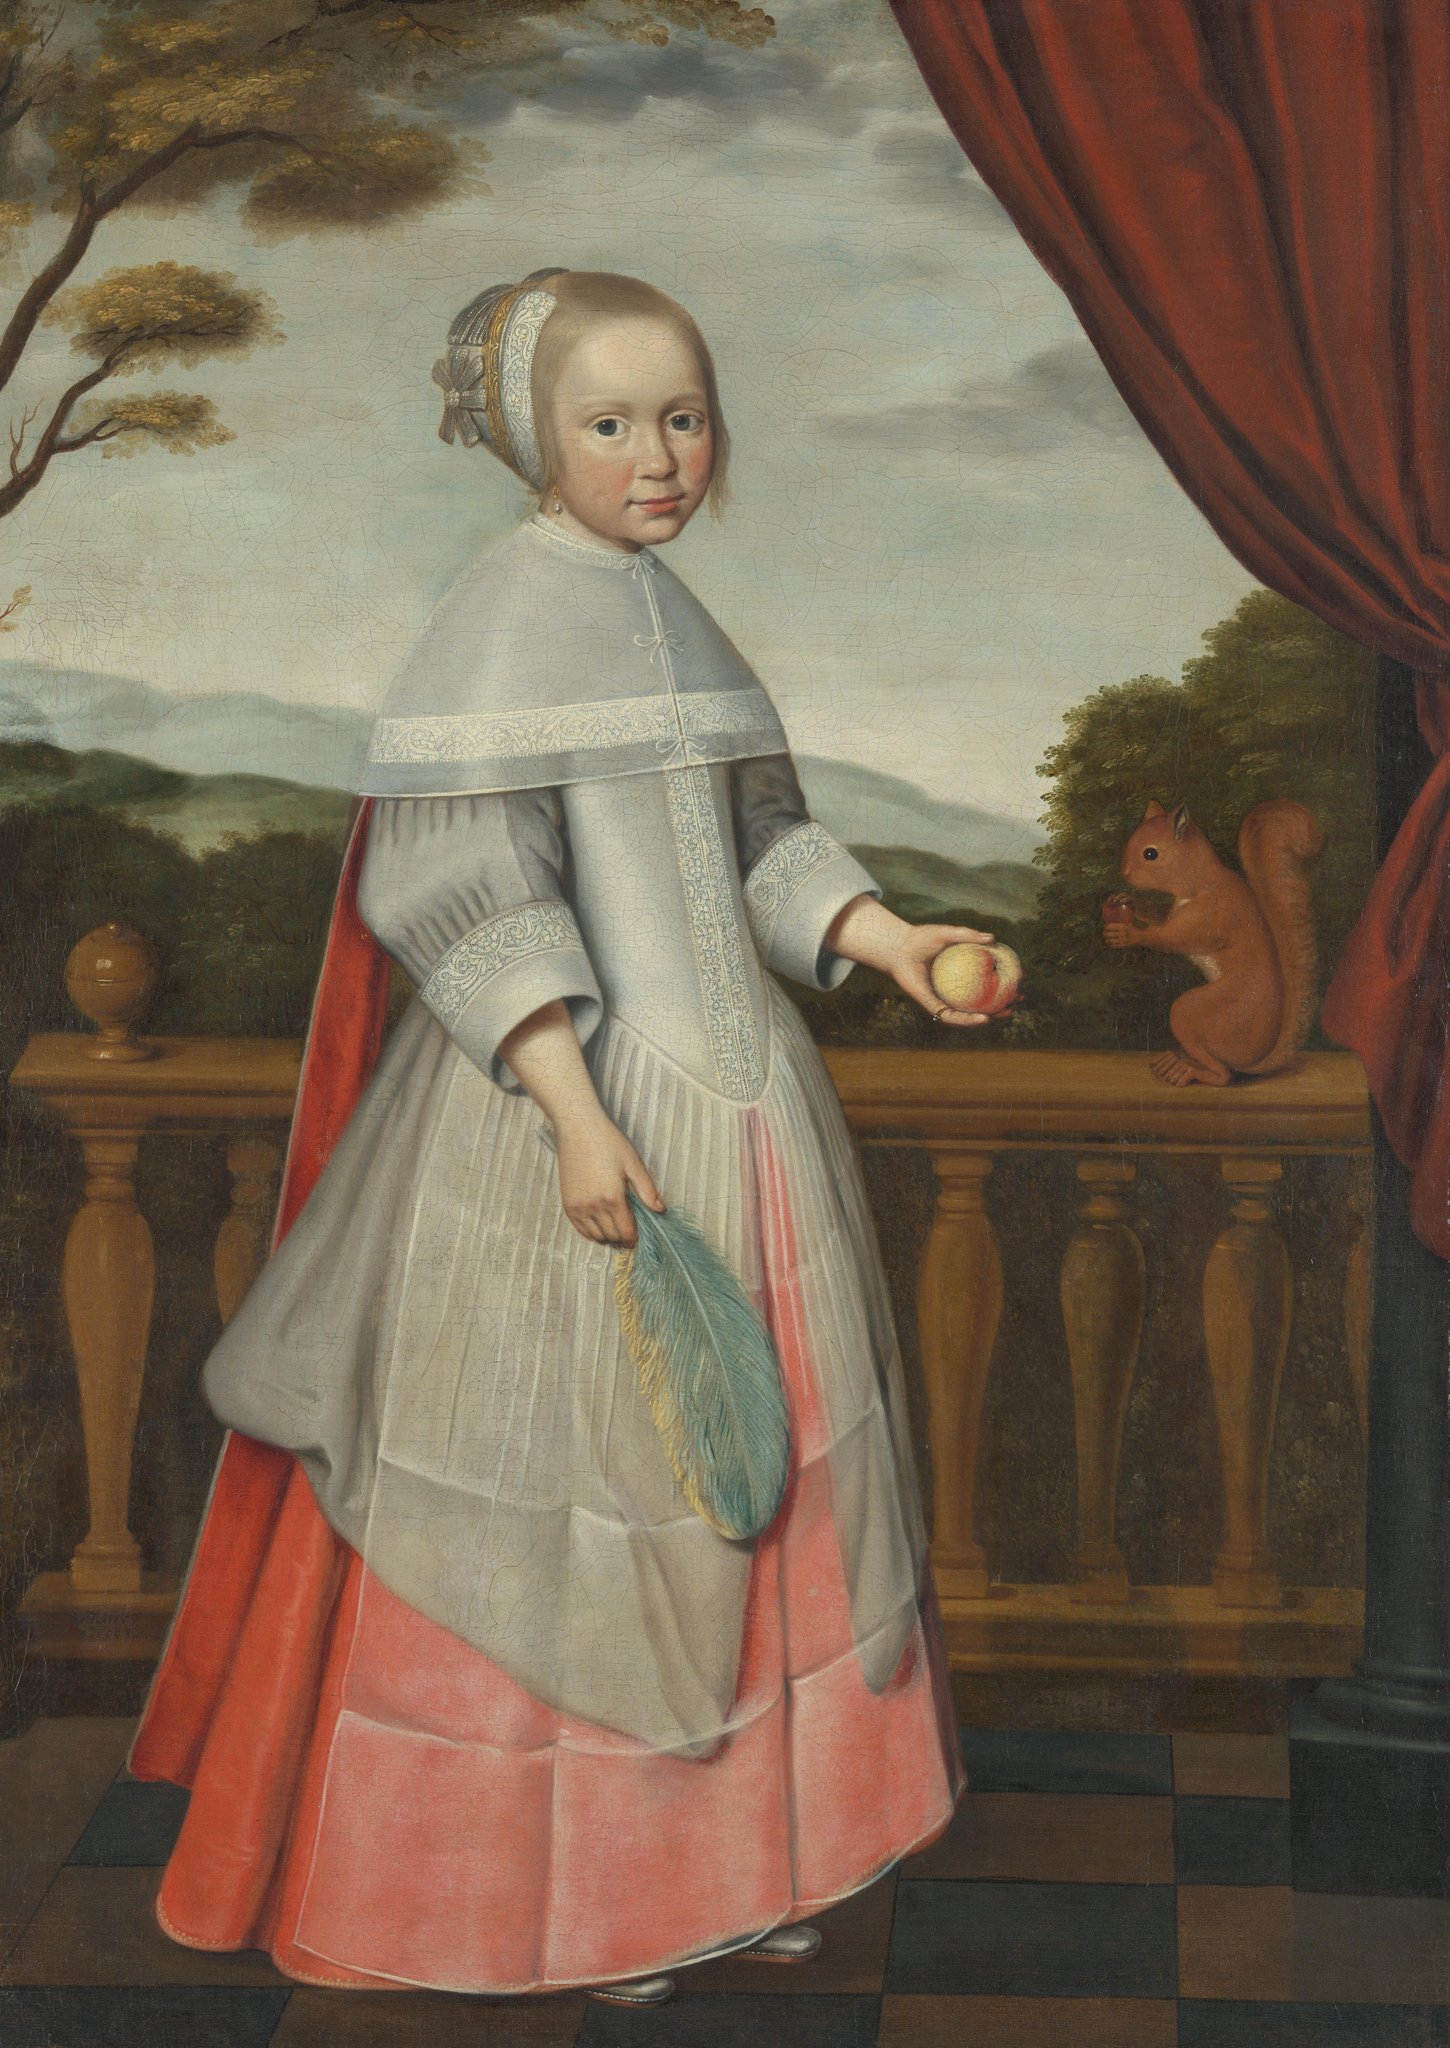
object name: painting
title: Portrait of a Girl, perhaps of the van Riebeeck Family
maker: willem jansz. ploy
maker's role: painter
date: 1663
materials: canvas, oil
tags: historical persons - bb - woman, girl (child between toddler and youth), rodents: squirrel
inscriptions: inscription and date: ‘Aetatis ... Aº 1663’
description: W.J. Ploy (attributed), 1663. Elisabeth van Oosten (1660 - 1714), half-sister of Johannes van Rees, as a child. Oil on canvas. This portrait is traditionally assumed to show a member of the Van Riebeeck family. Jan van Riebeeck (1619 - 1677) arrived at Cape of Good Hope in 1652 and established a supply base for VOC ships sailing to Batavia (Jakarta). The actual identity of the subject is not certain.